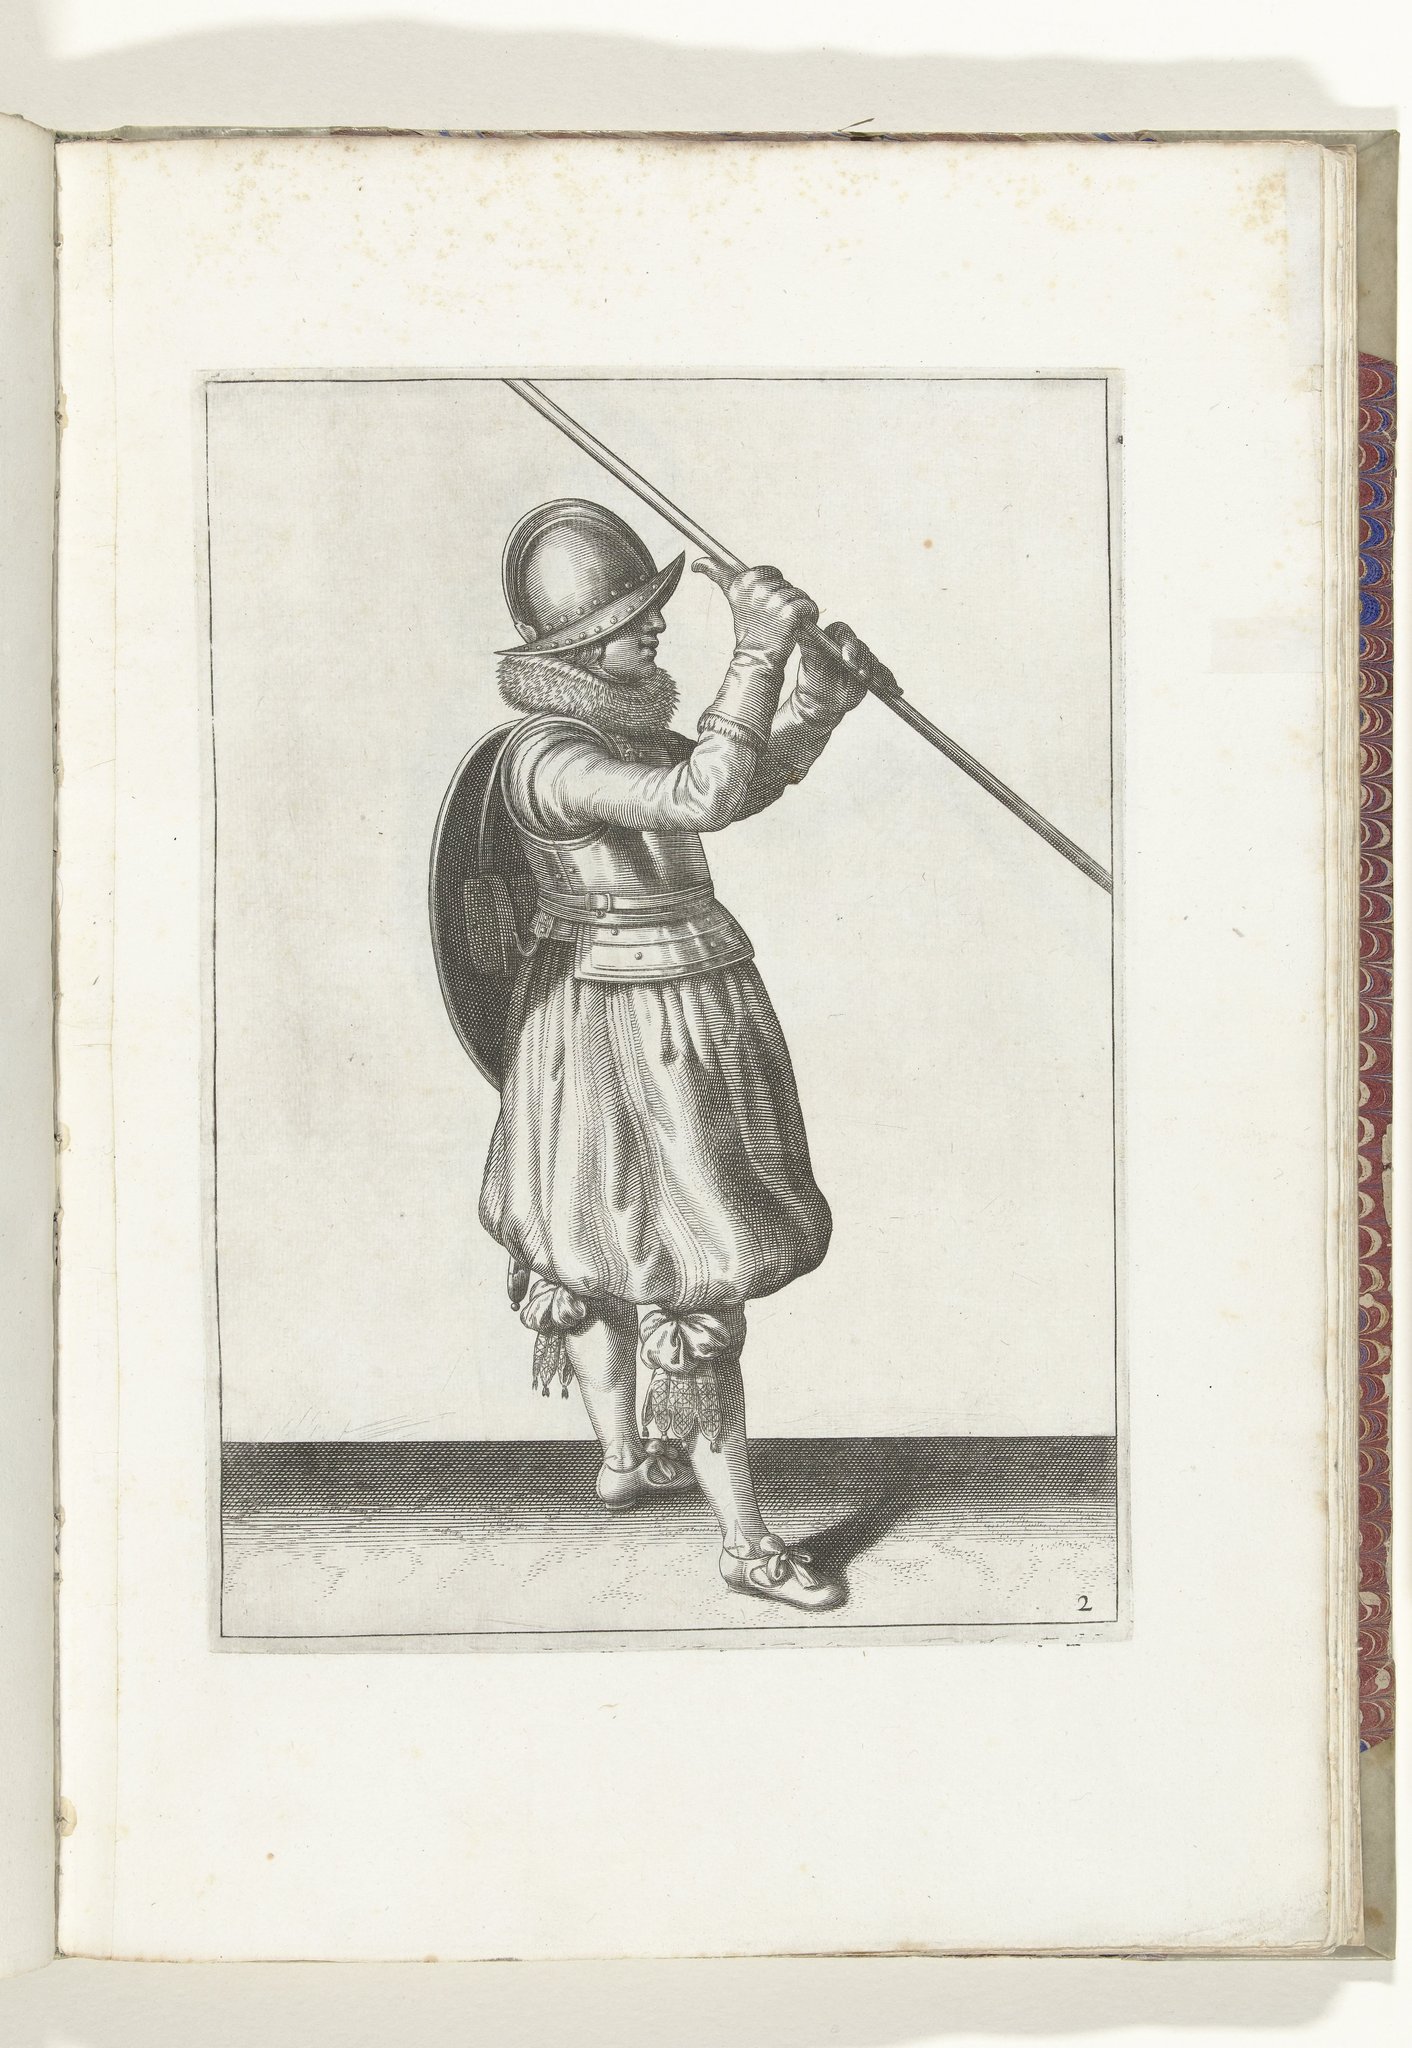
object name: print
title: De exercitie met schild en spies: de soldaat met de spies schuin in beide handen en het schild op de rug (nr. 2), 1618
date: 1616-1618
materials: paper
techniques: engraving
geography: northern netherlands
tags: maurice (prince of orange), handling of weapons ~ military training, weapons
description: Illustratie in: Adam van Breen, De Nassausche Wapen-Handelinge, van Schilt, Spies, Rappier ende Targe : beyde figuerlick afgebeelt, ende gestelt na de nieu ordening [van] ... Maurits van Nassau, 's-Gravenhage, [Aert Meuris] 1618, plaat nr. 2. In het exemplaar in de collectie van de Rijksmuseum Research Library (326 F 22).